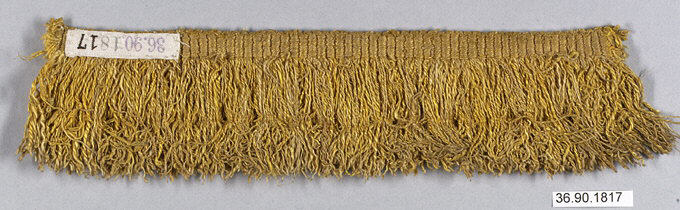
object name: fringe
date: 1601-1700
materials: silk